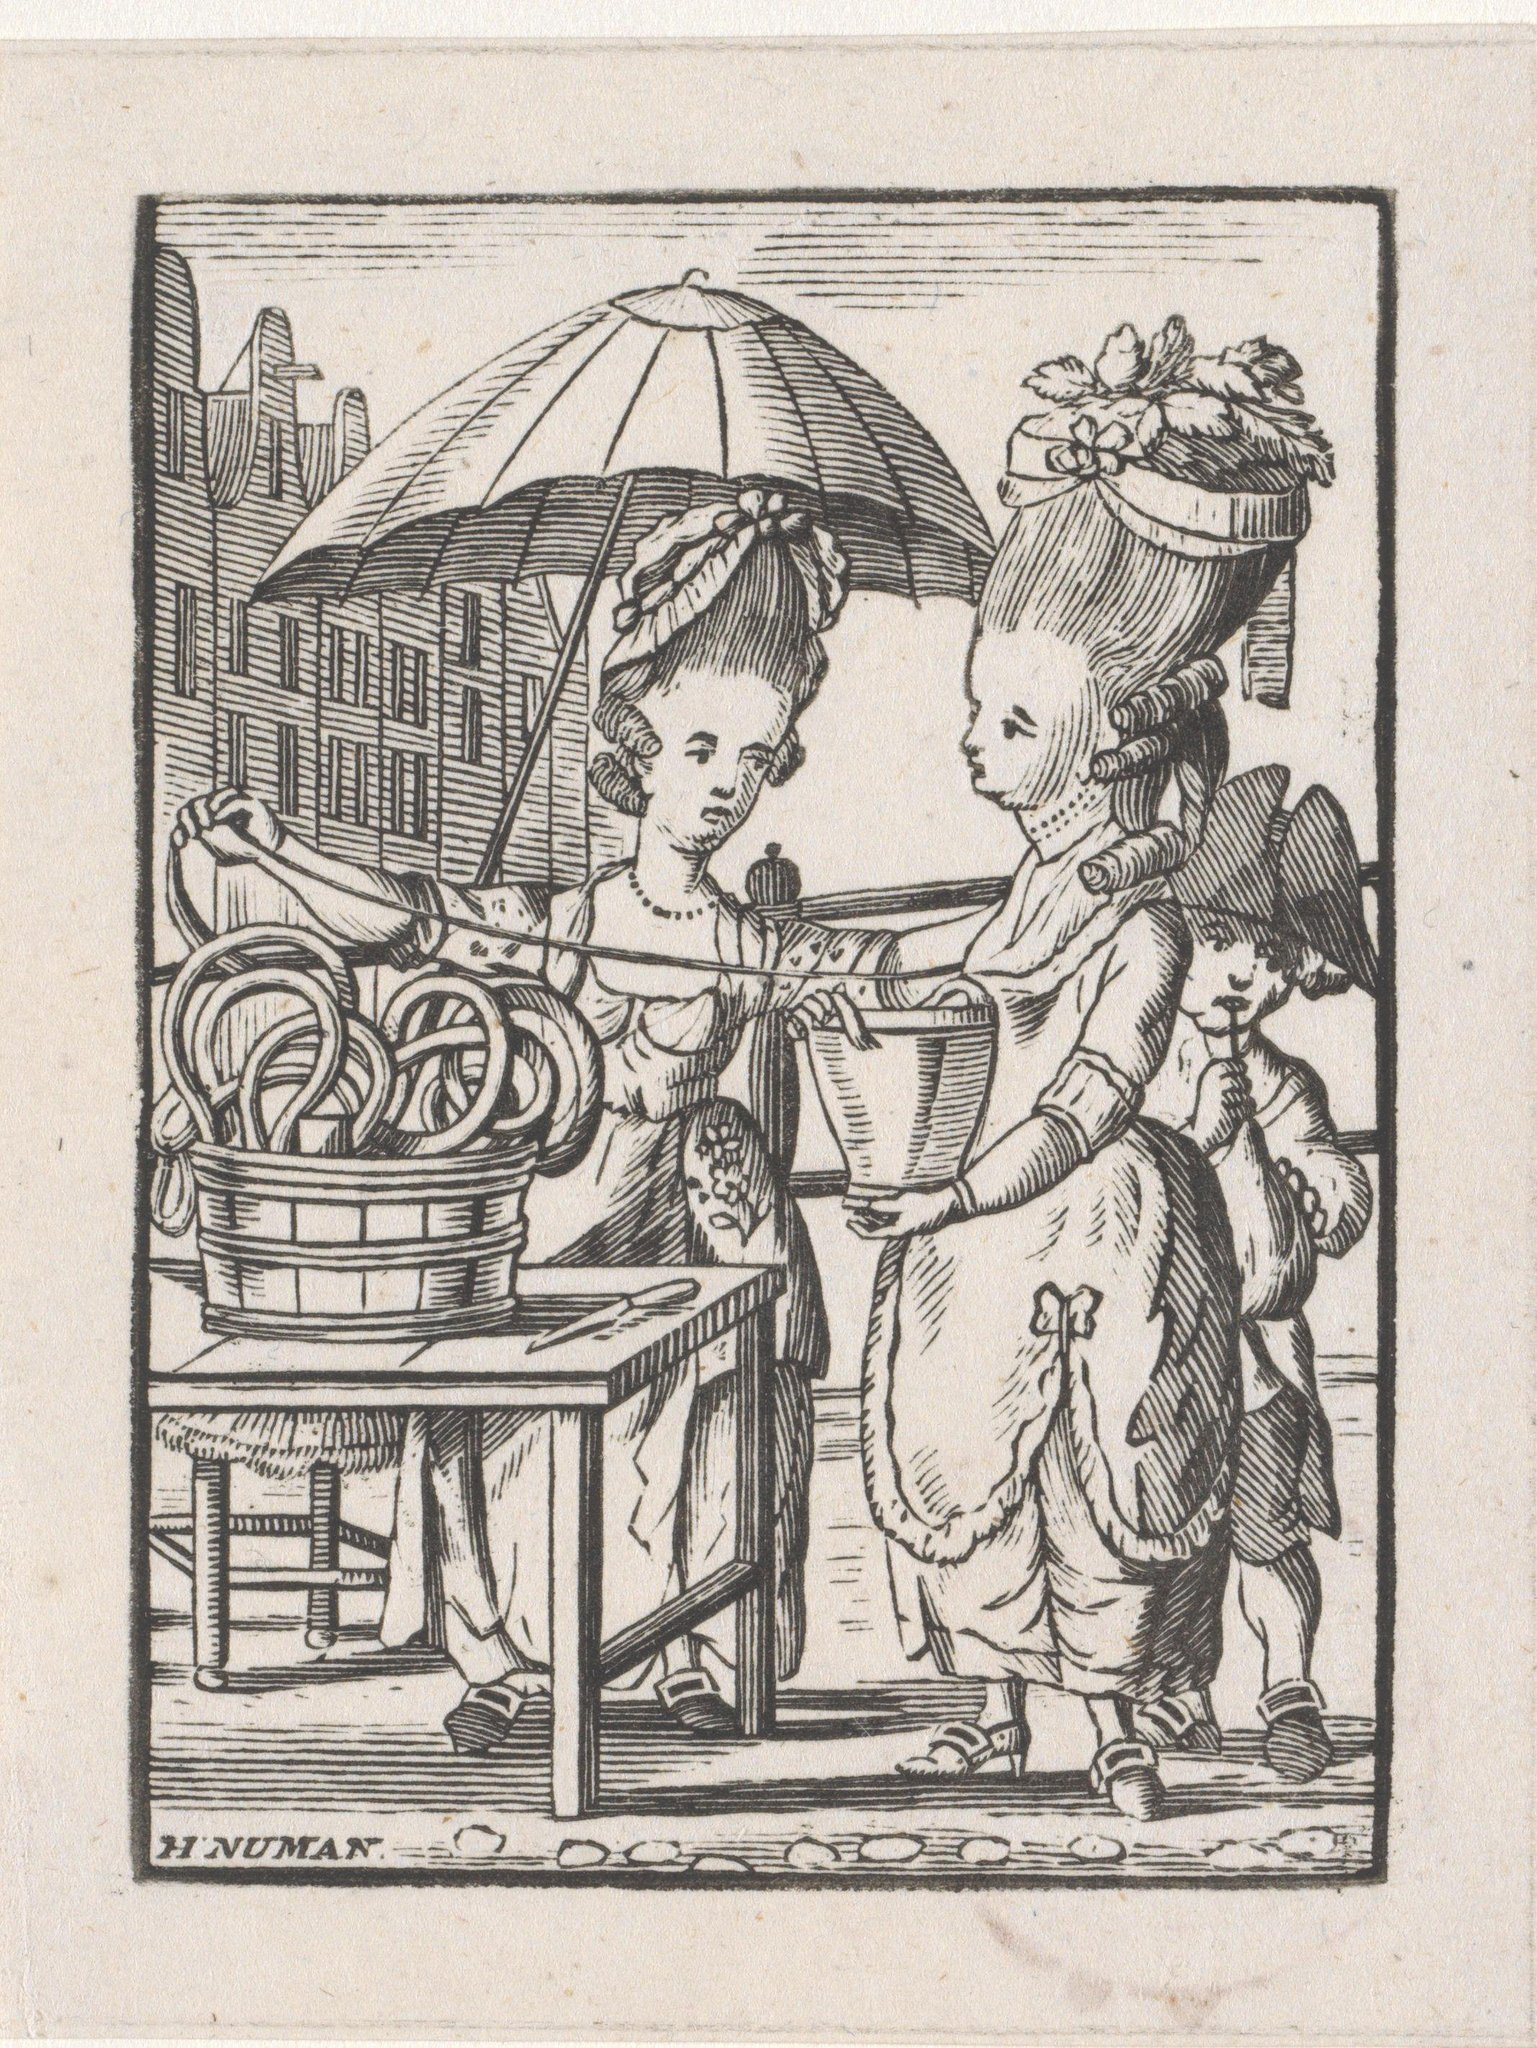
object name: print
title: Straatverkoopster van draad met een klant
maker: hendrik numan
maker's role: draughtsman, print maker, publisher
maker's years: 1736-1788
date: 1746-1788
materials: paper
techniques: woodcut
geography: haarlem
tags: street-trader, customer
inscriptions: collector's mark: Lugt 240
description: Numan maakte deze prent voor het 'Derde vervolg van De Zegepraal der mode' uit 1784. Deze afdruk hier is niet in boekvorm verschenen.